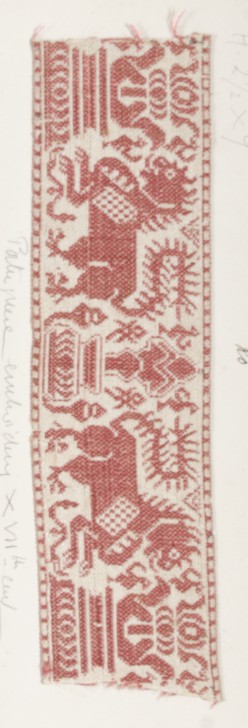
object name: fragment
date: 1601-1700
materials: silk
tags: lions